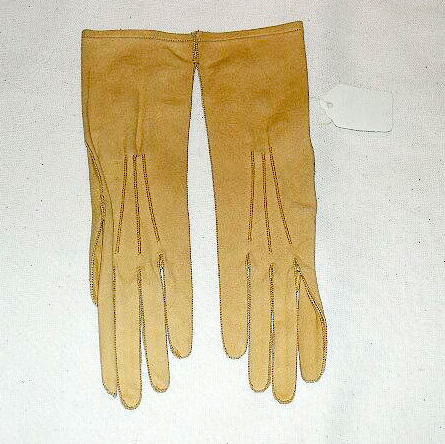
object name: glove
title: Gloves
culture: french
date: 1878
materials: leather, steel